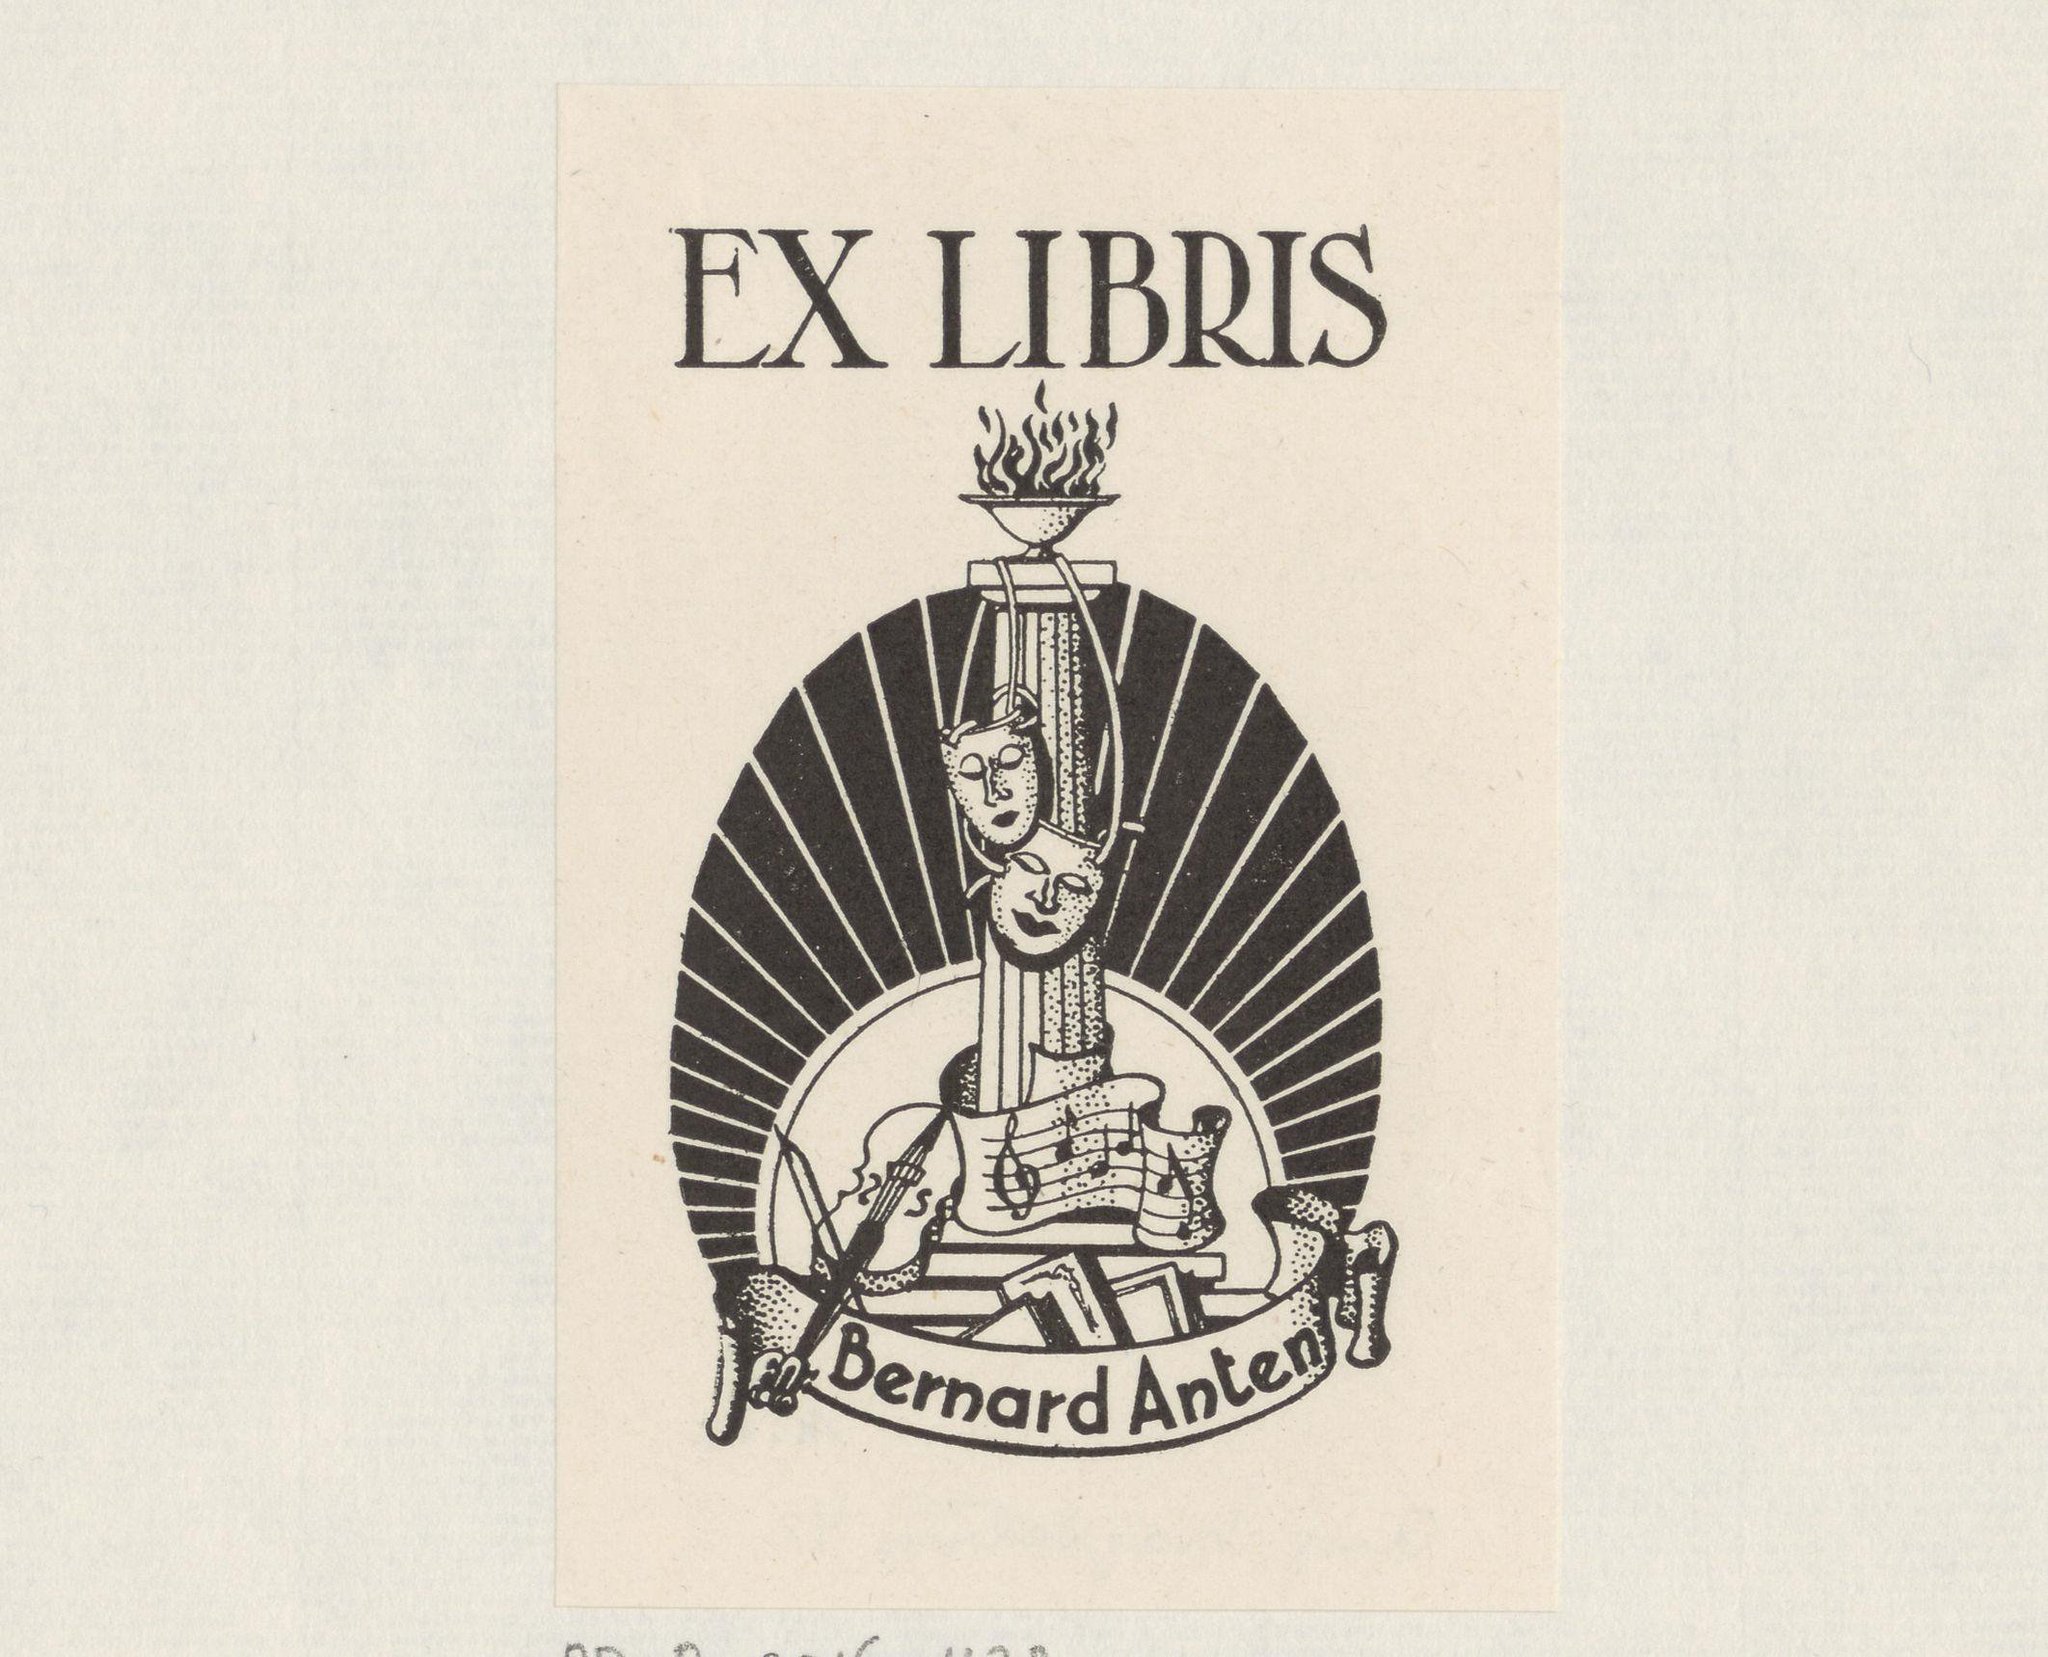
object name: bookplate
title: Ex libris van Bernard Anten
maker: auguste magdelijns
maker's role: print maker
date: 1942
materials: paper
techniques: printing block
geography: netherlands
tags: notation of music, tragedy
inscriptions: inscription: ‘Aug. Magdelijns '42’